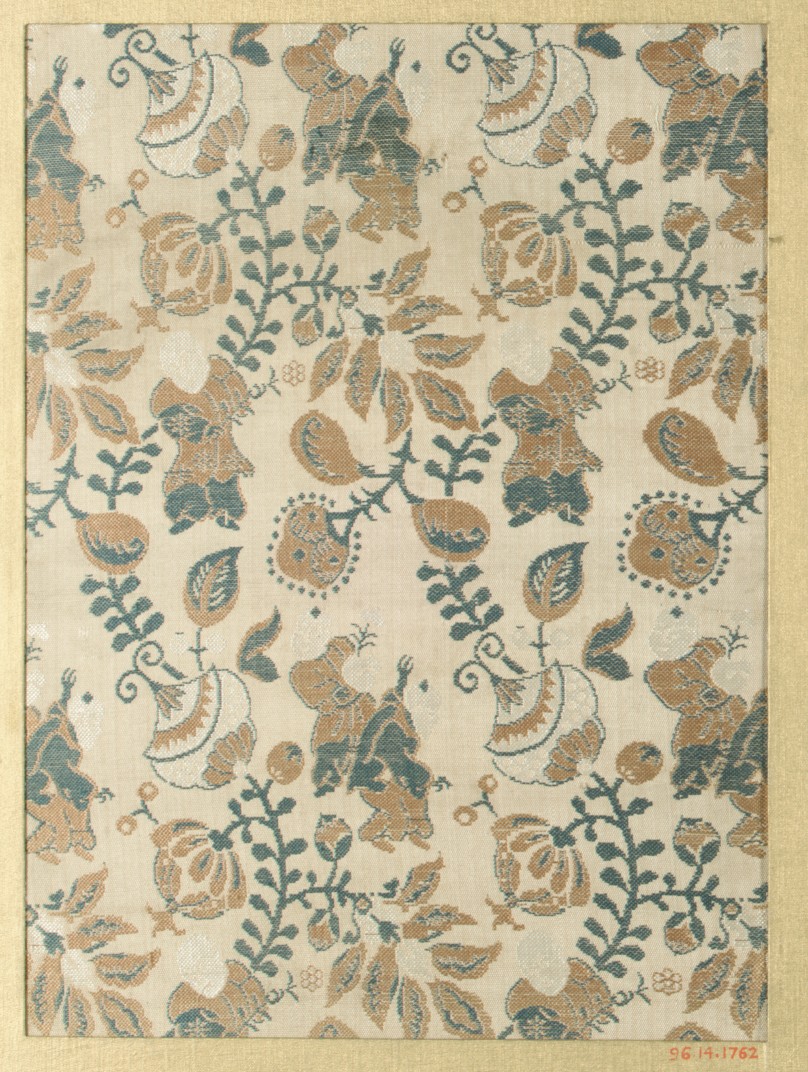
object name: piece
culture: japanese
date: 1701-1900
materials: silk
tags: flowers